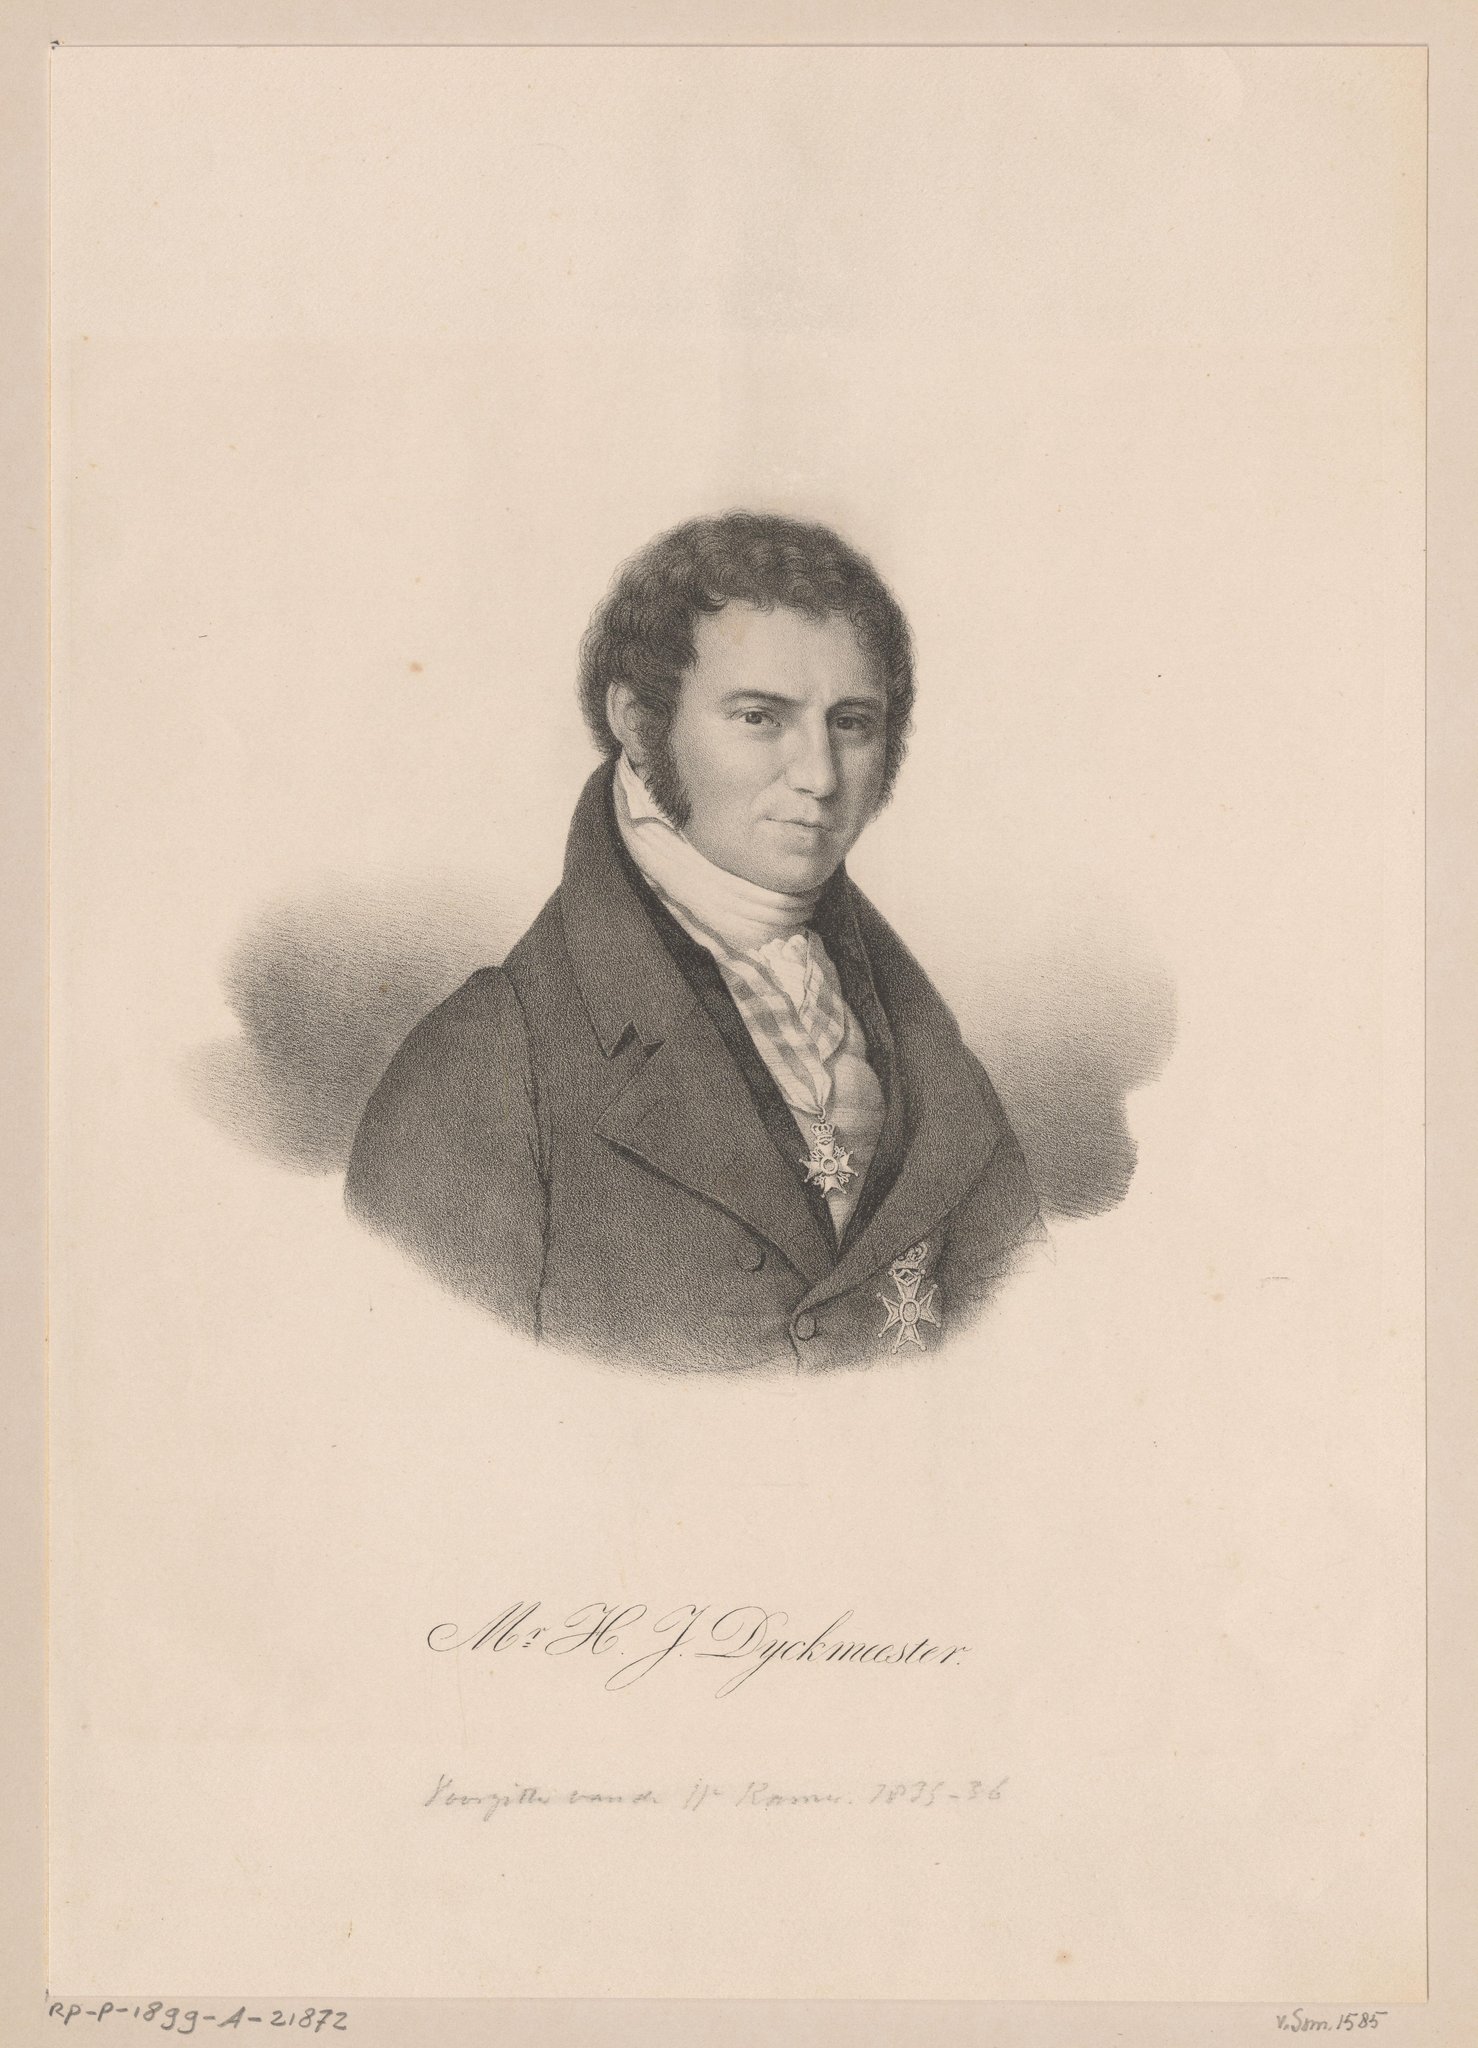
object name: print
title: Portret van Herman Jacob Dijckmeester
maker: Anonymous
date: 1810-1849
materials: paper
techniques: lithograph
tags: politician, historical persons, politician, e.g. party leader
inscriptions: collector's mark: Lugt 2228